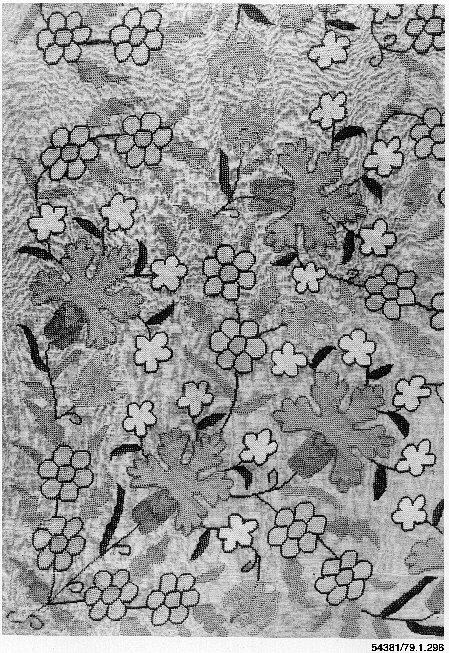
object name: textile fragment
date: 1701-1800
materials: linen, silk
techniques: embroidery, weave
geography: greece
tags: flowers